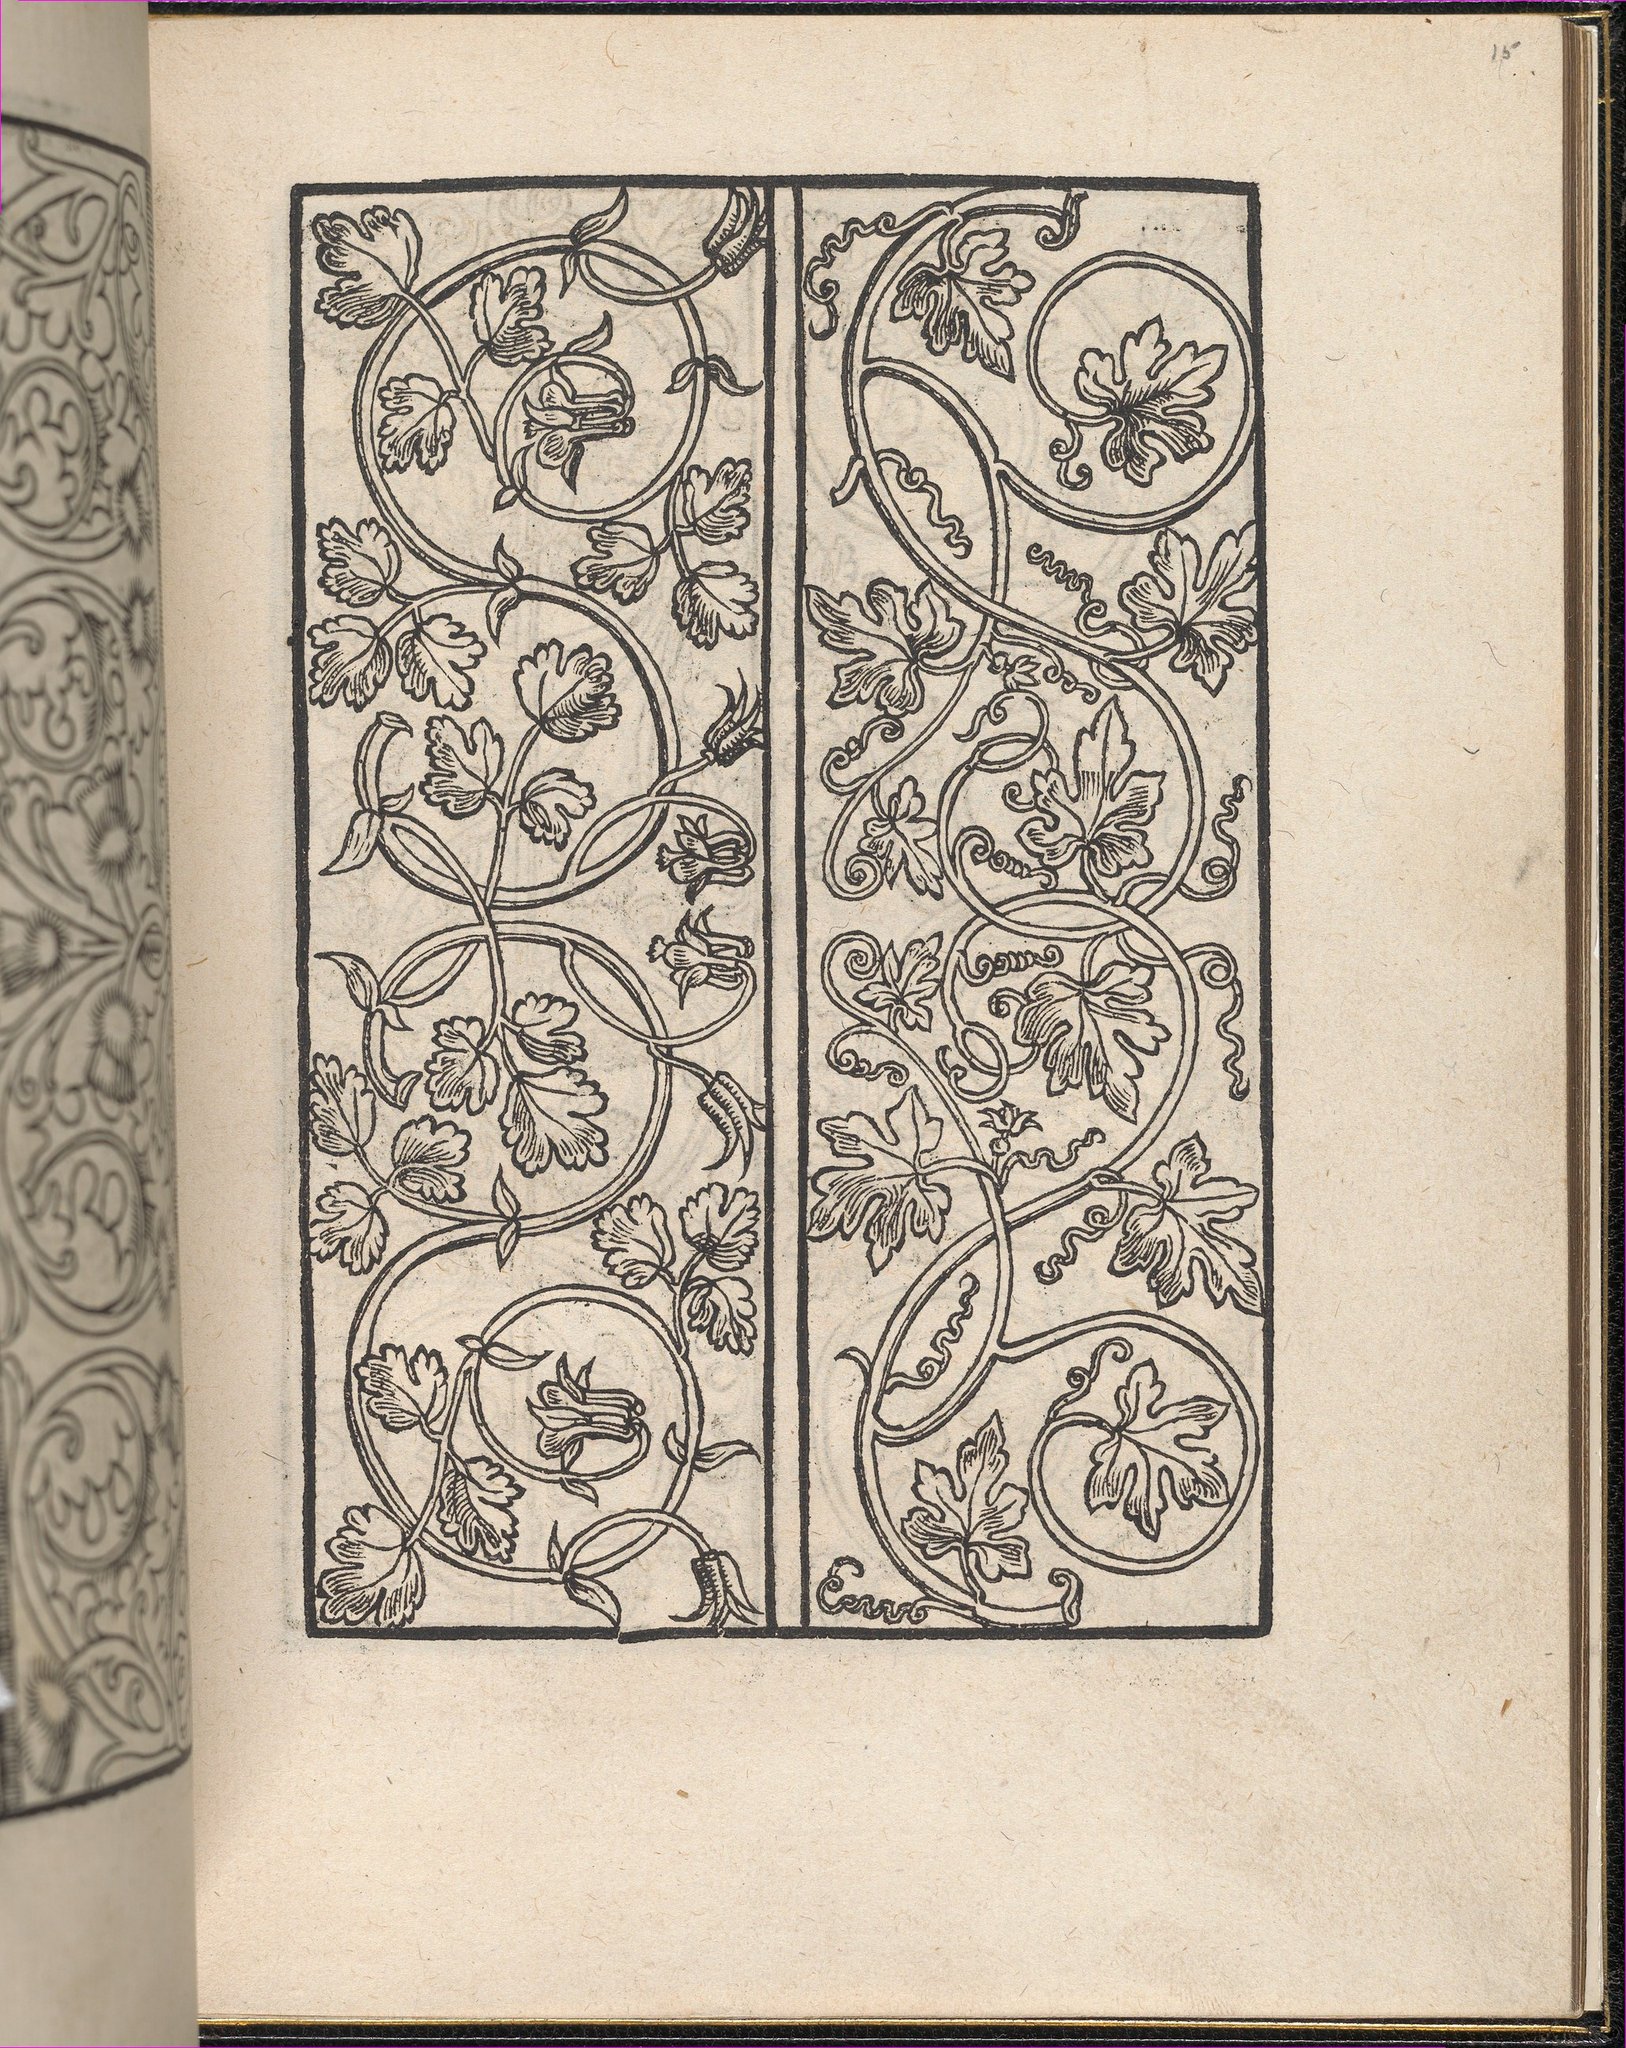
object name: book print ornament architecture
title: Page from Ein new kunstlich Modelbuch...(Page 15r)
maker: peter quentel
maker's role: publisher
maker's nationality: german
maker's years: 1500-1550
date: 1544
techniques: woodcut